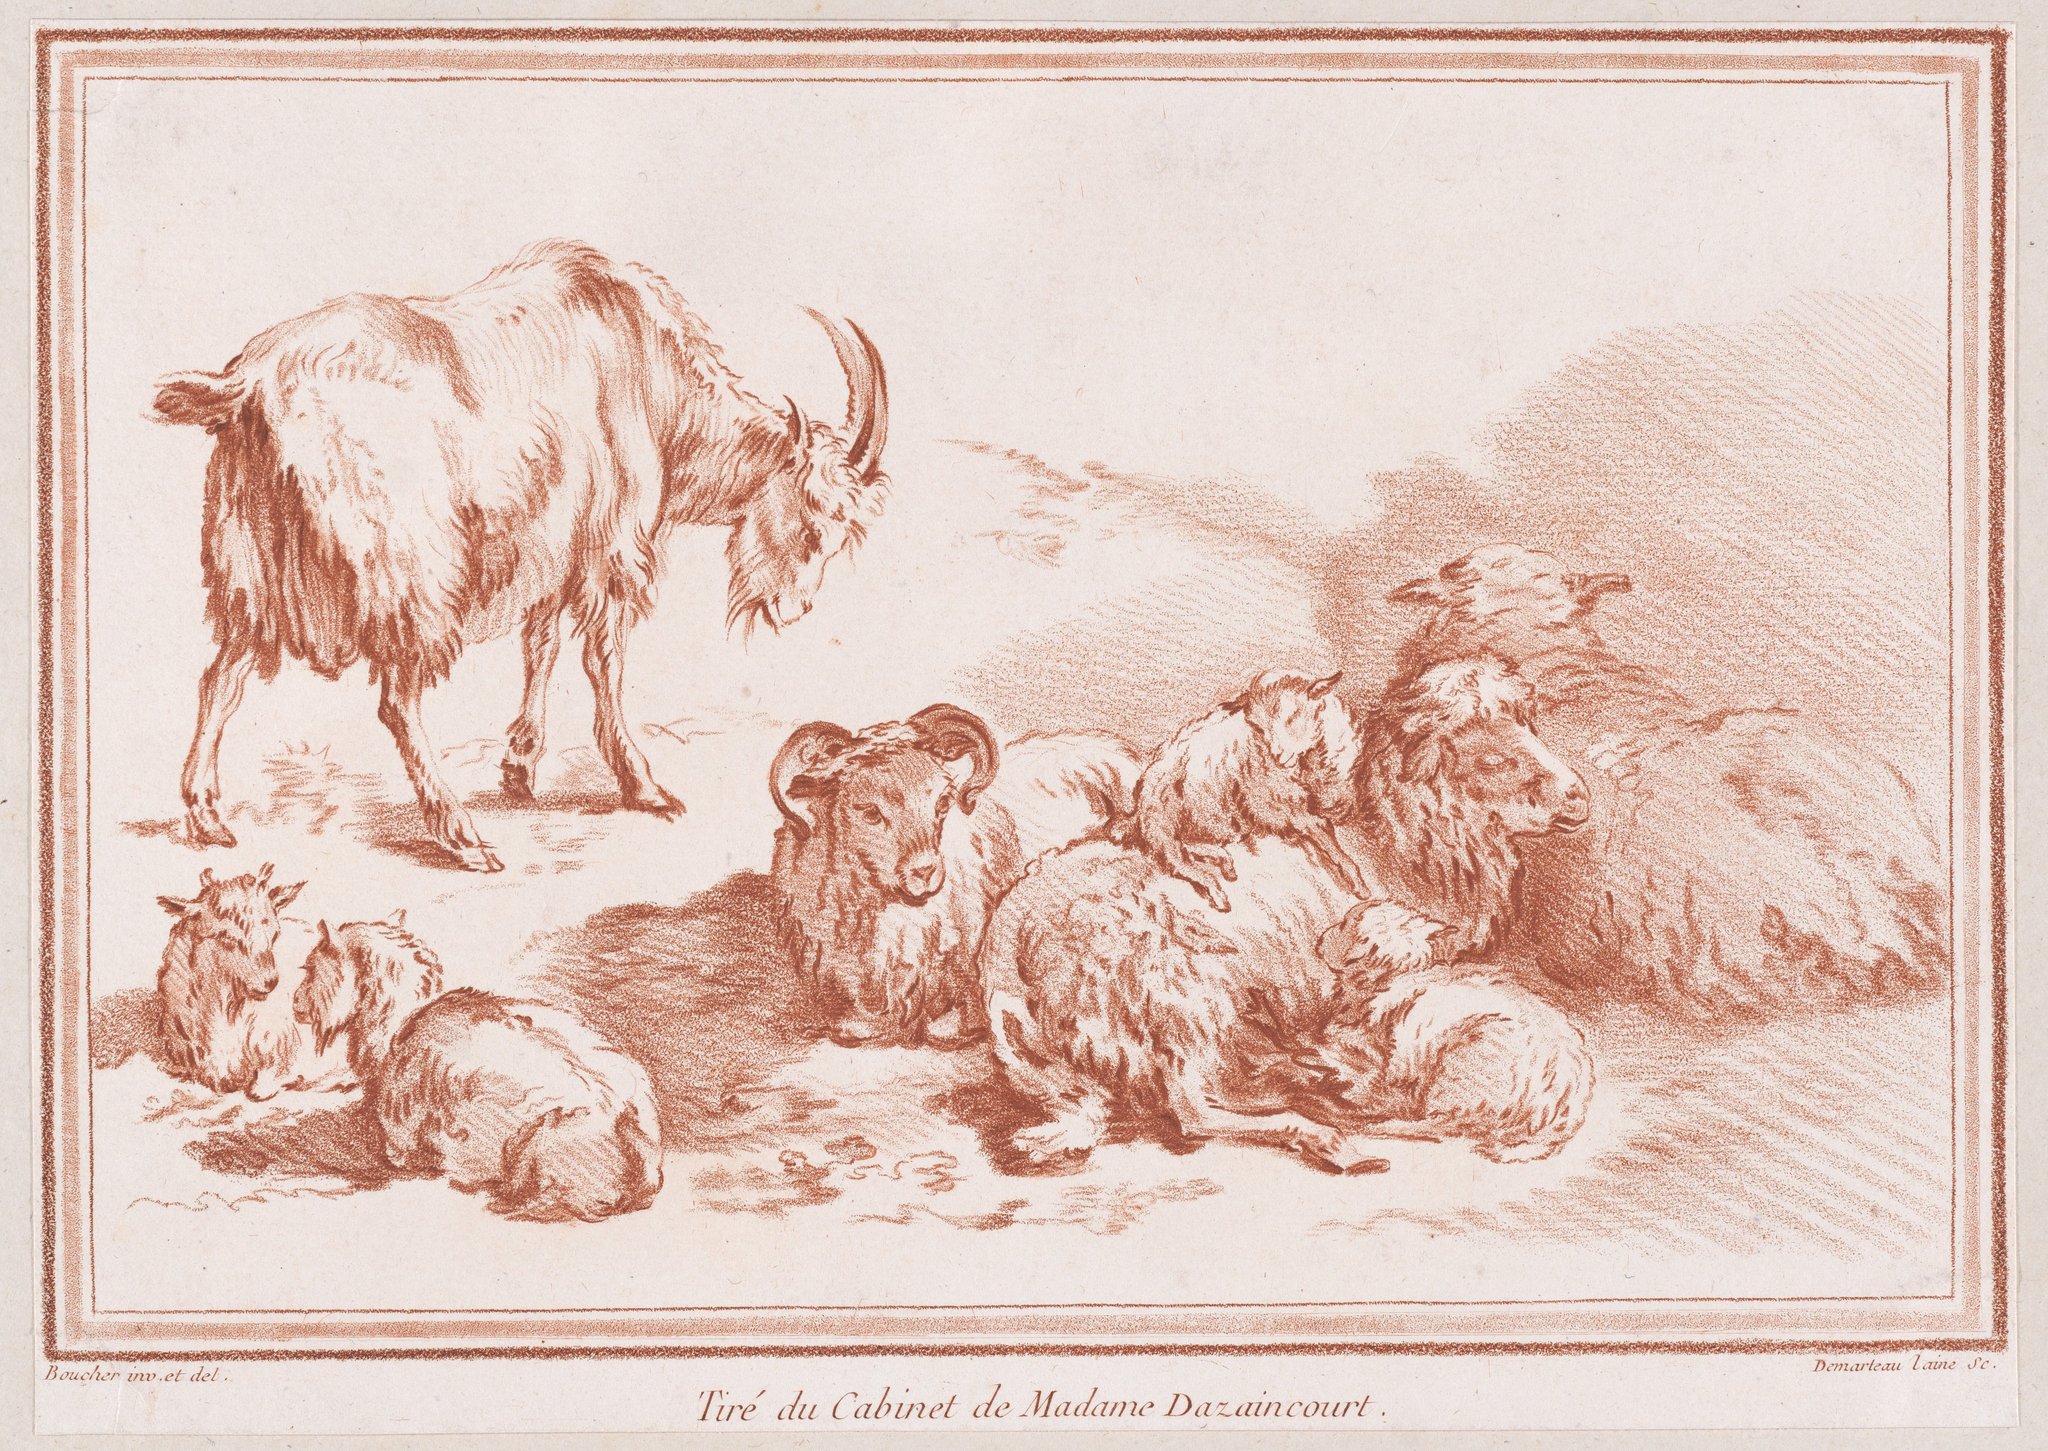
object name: print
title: Chèvre, chevreaux et moutons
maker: gilles demarteau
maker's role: artist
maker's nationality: french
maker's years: 1722-1776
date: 1701-1800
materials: ink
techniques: printmaking, etching, printing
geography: france